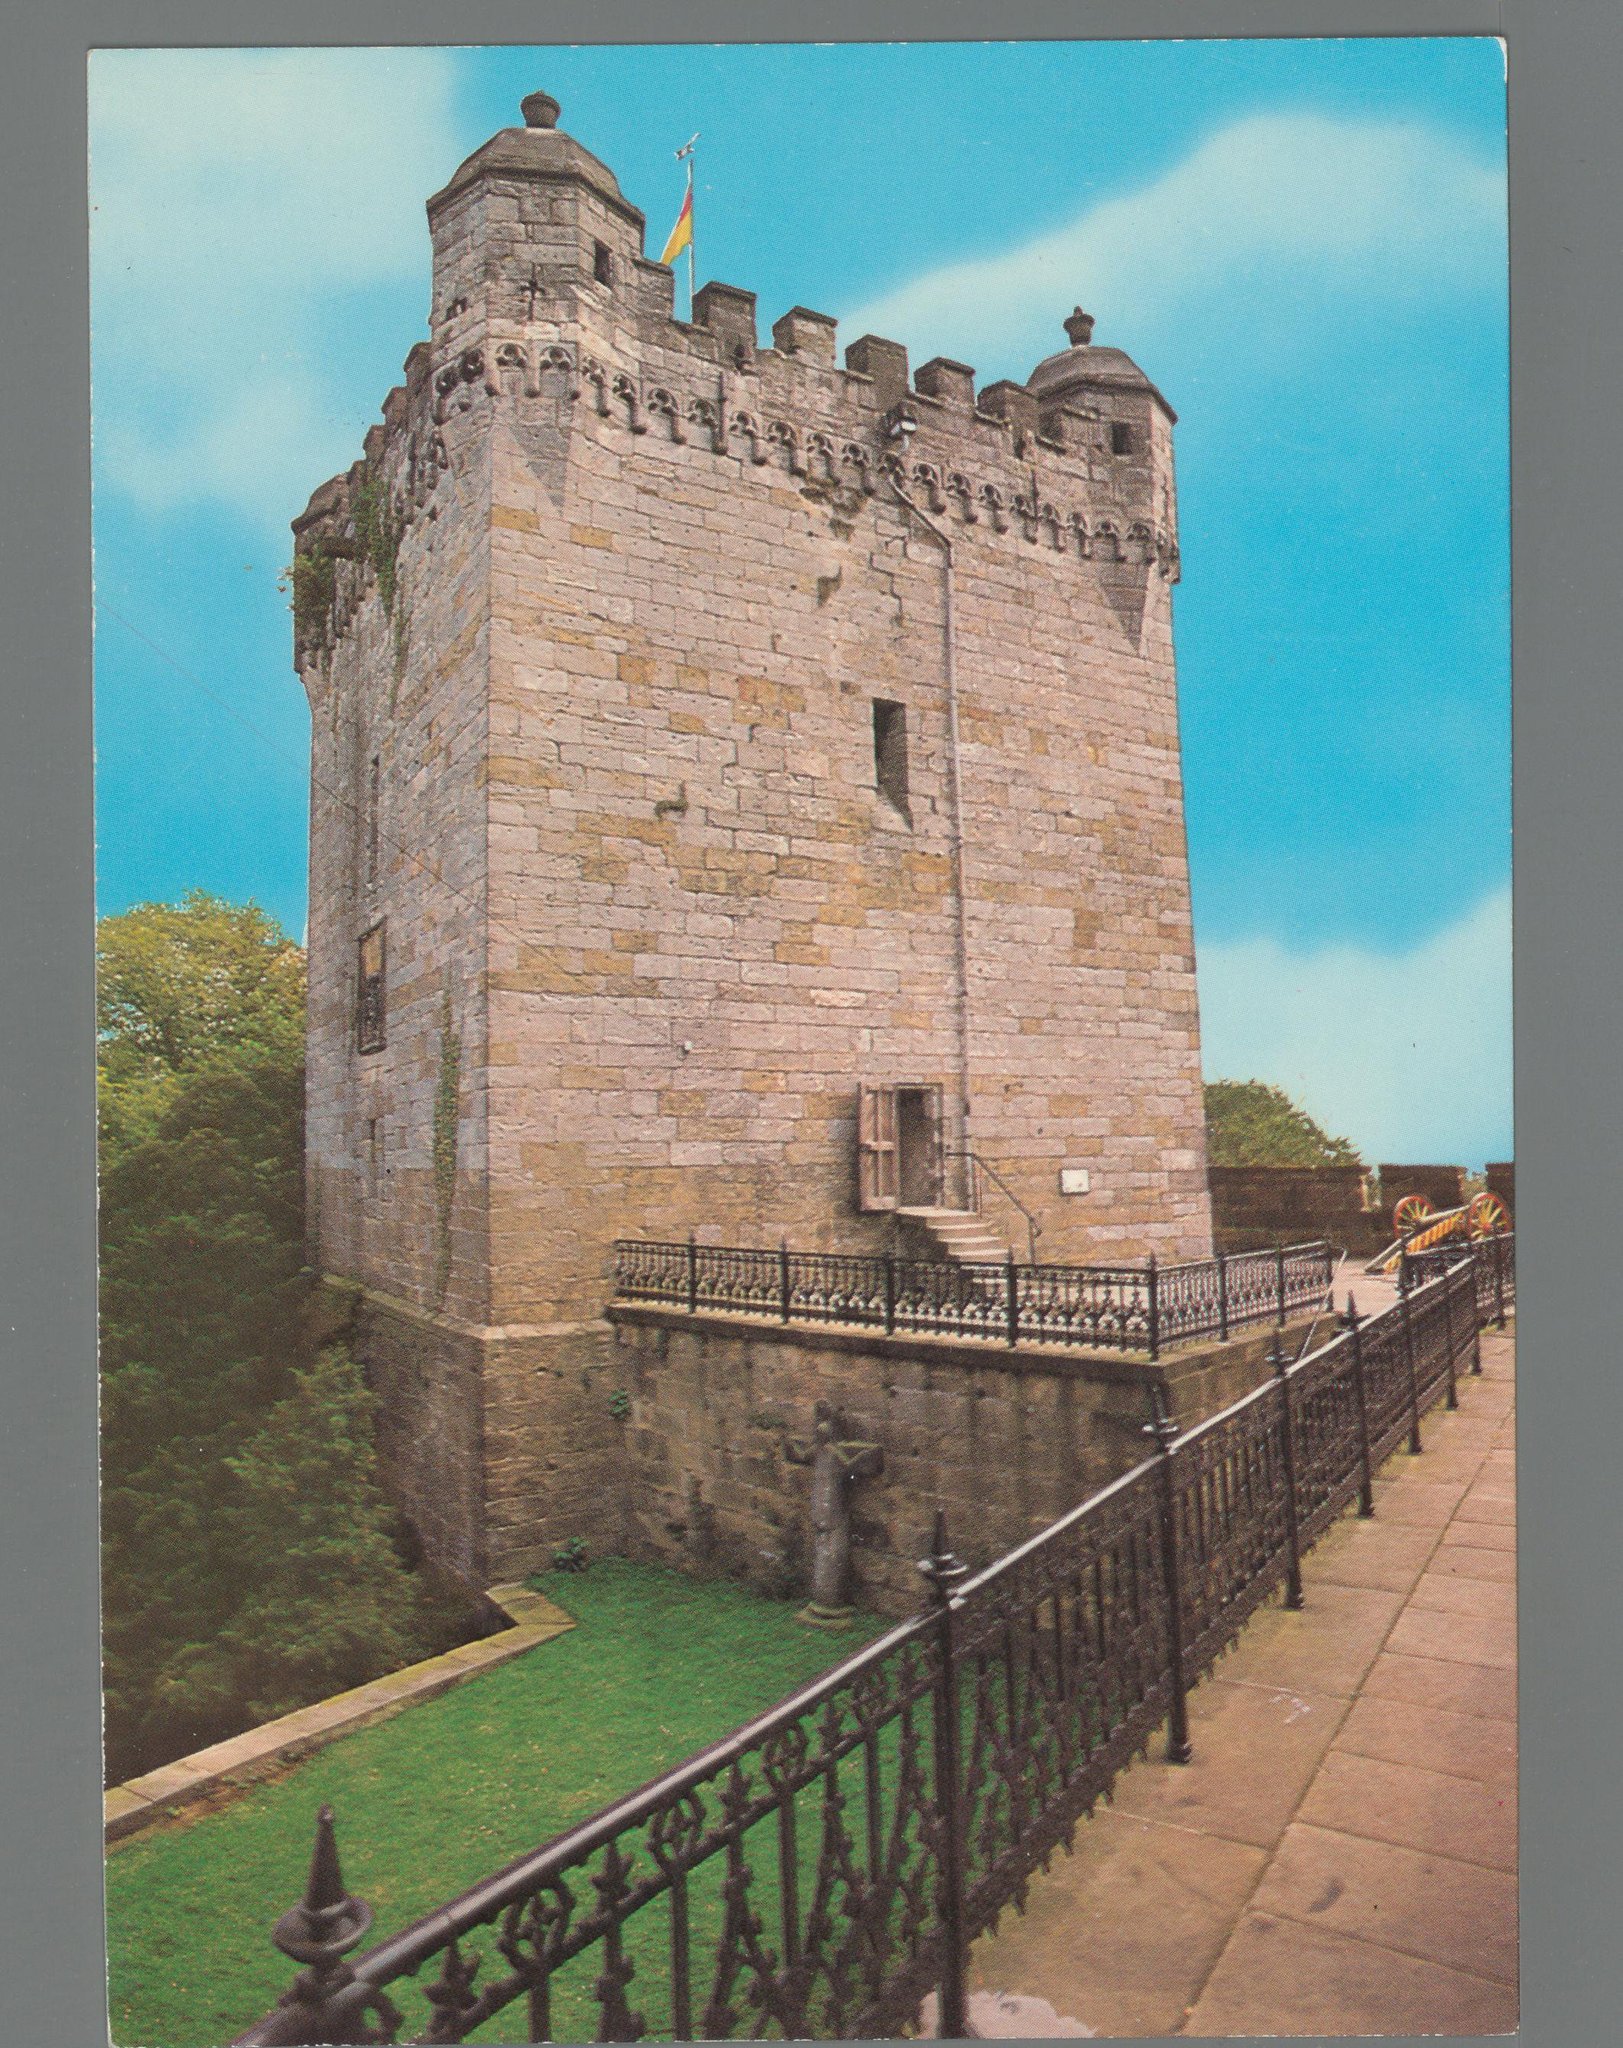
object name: ansichtkaart, prentbriefkaart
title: Bad Bentheim. Pulverturm auf der Burg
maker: Anonymous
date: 1960-2000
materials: cardboard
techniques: offset printed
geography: bad bentheim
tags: towers ~ fortified city